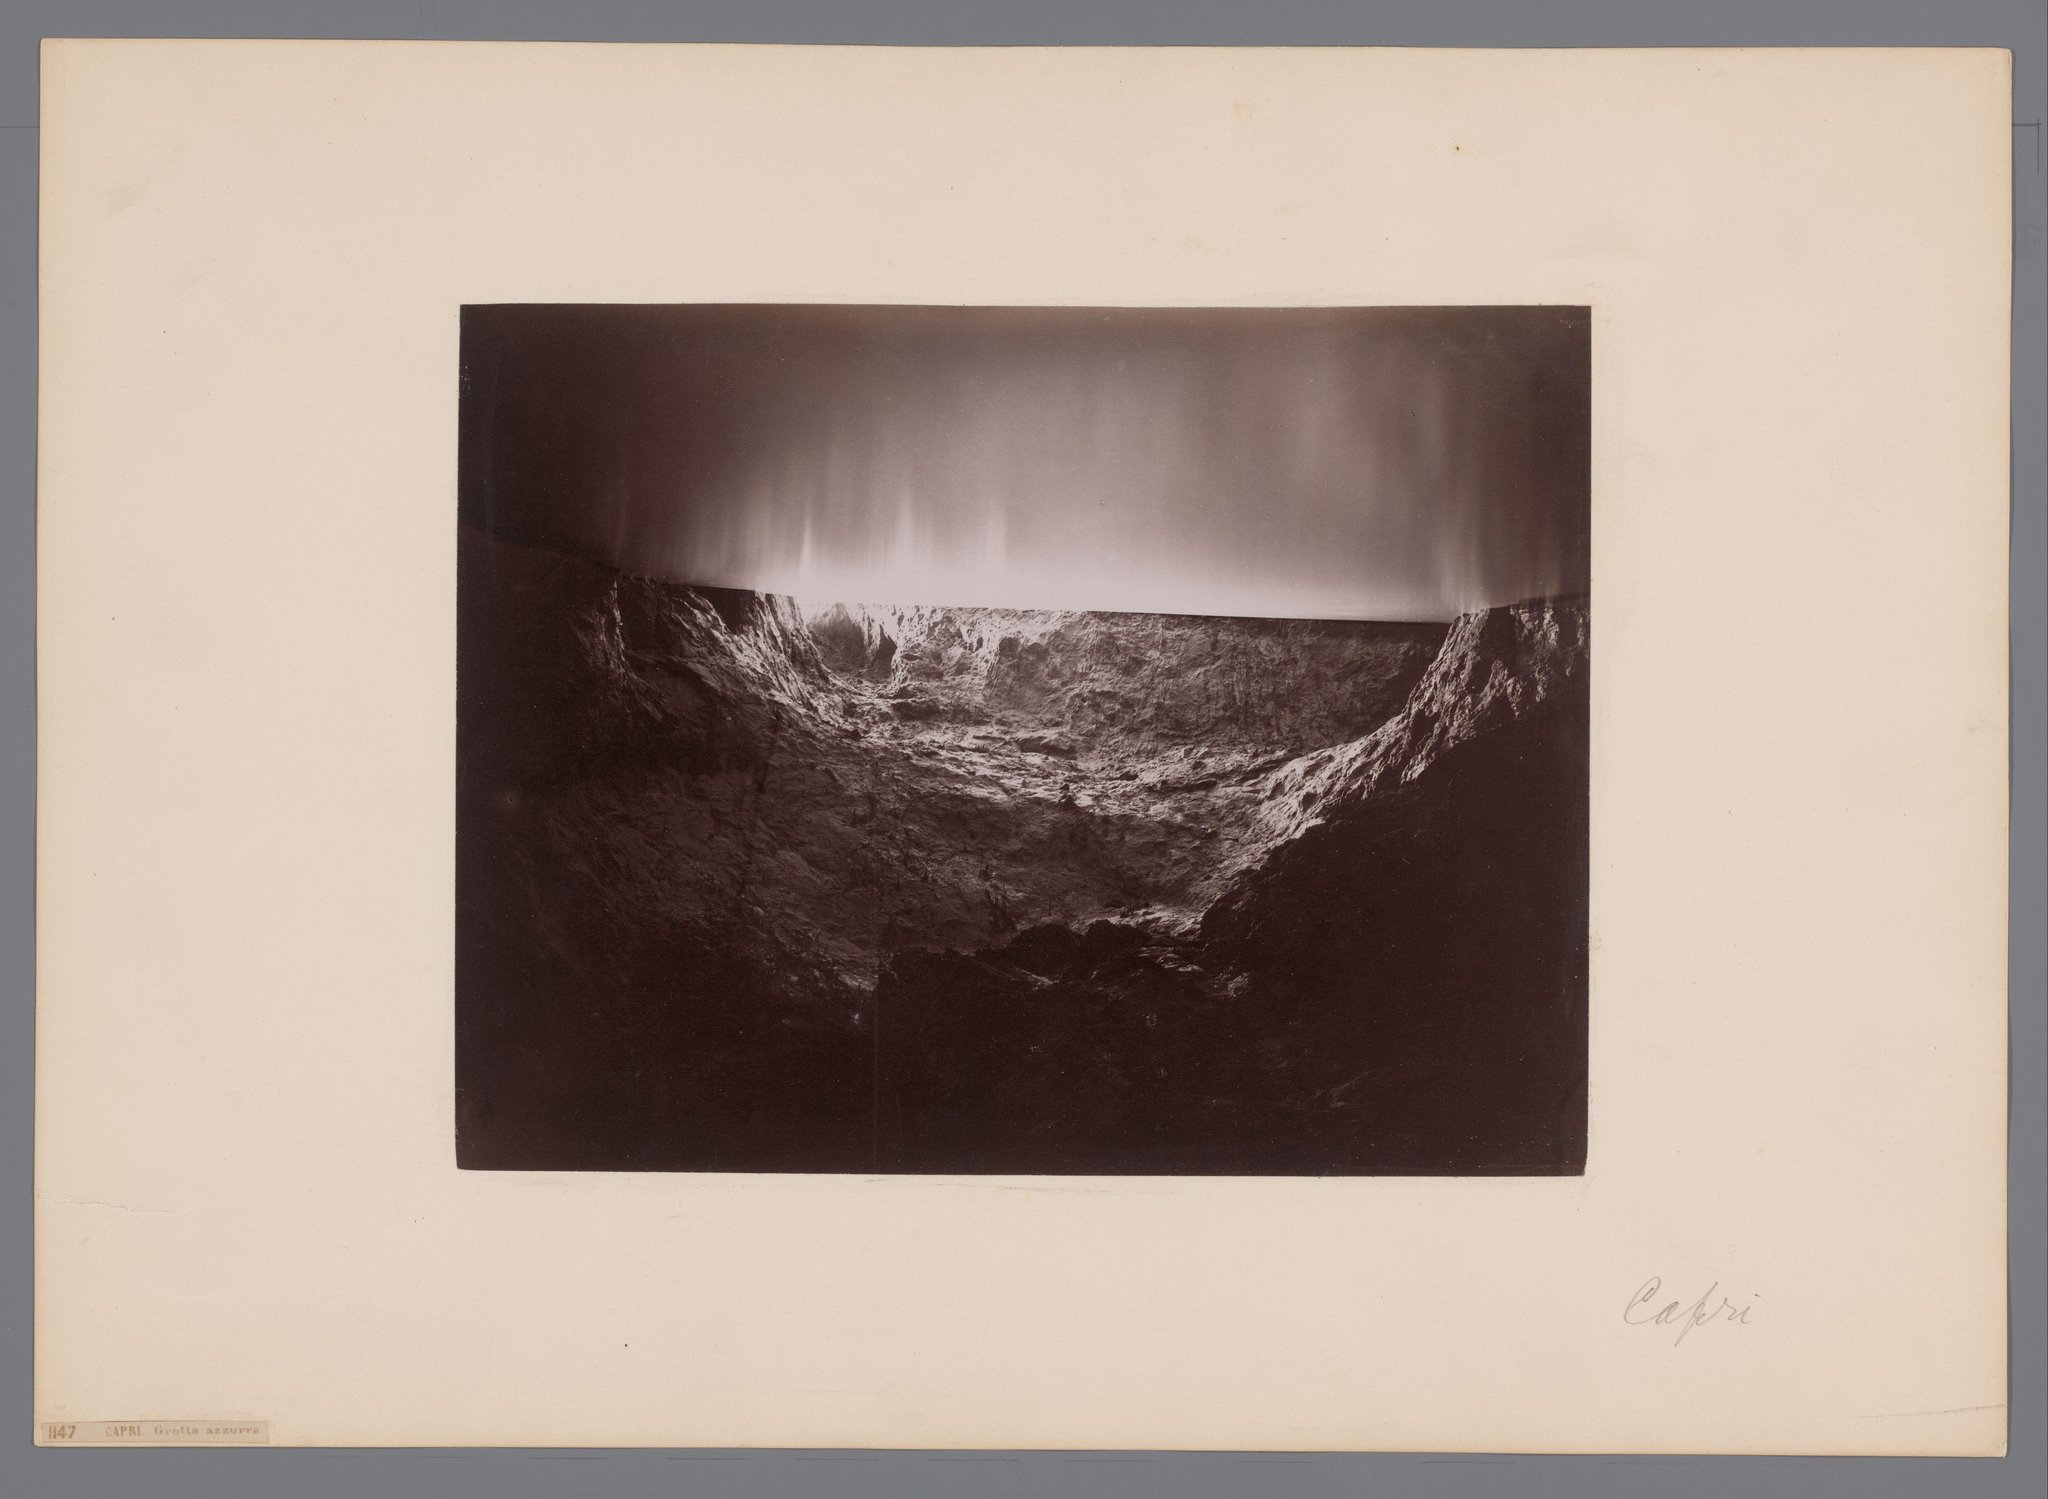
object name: photograph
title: Capri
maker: giorgio sommer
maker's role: fotograaf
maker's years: 1834-1914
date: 1857-1914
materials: cardboard, paper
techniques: albumen print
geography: capri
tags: cave, grotto, capri, isola di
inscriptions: number: ‘1147’